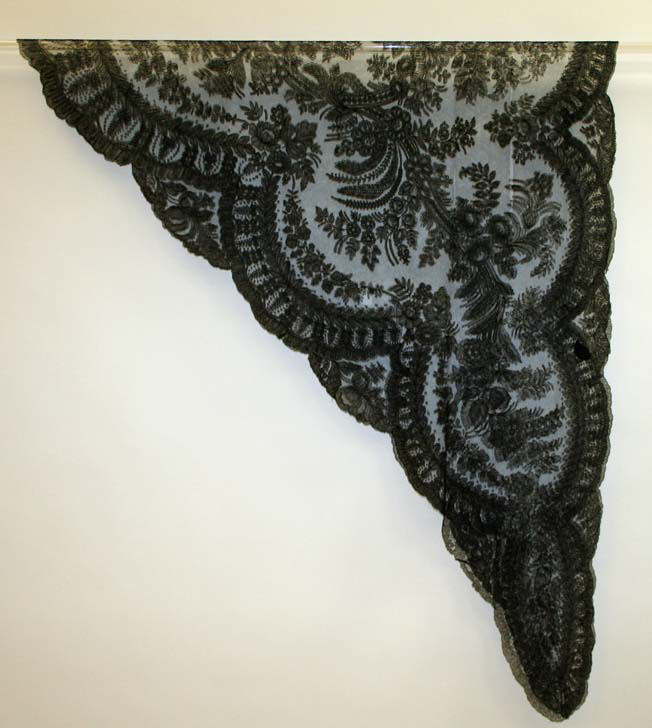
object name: shawl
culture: french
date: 1860